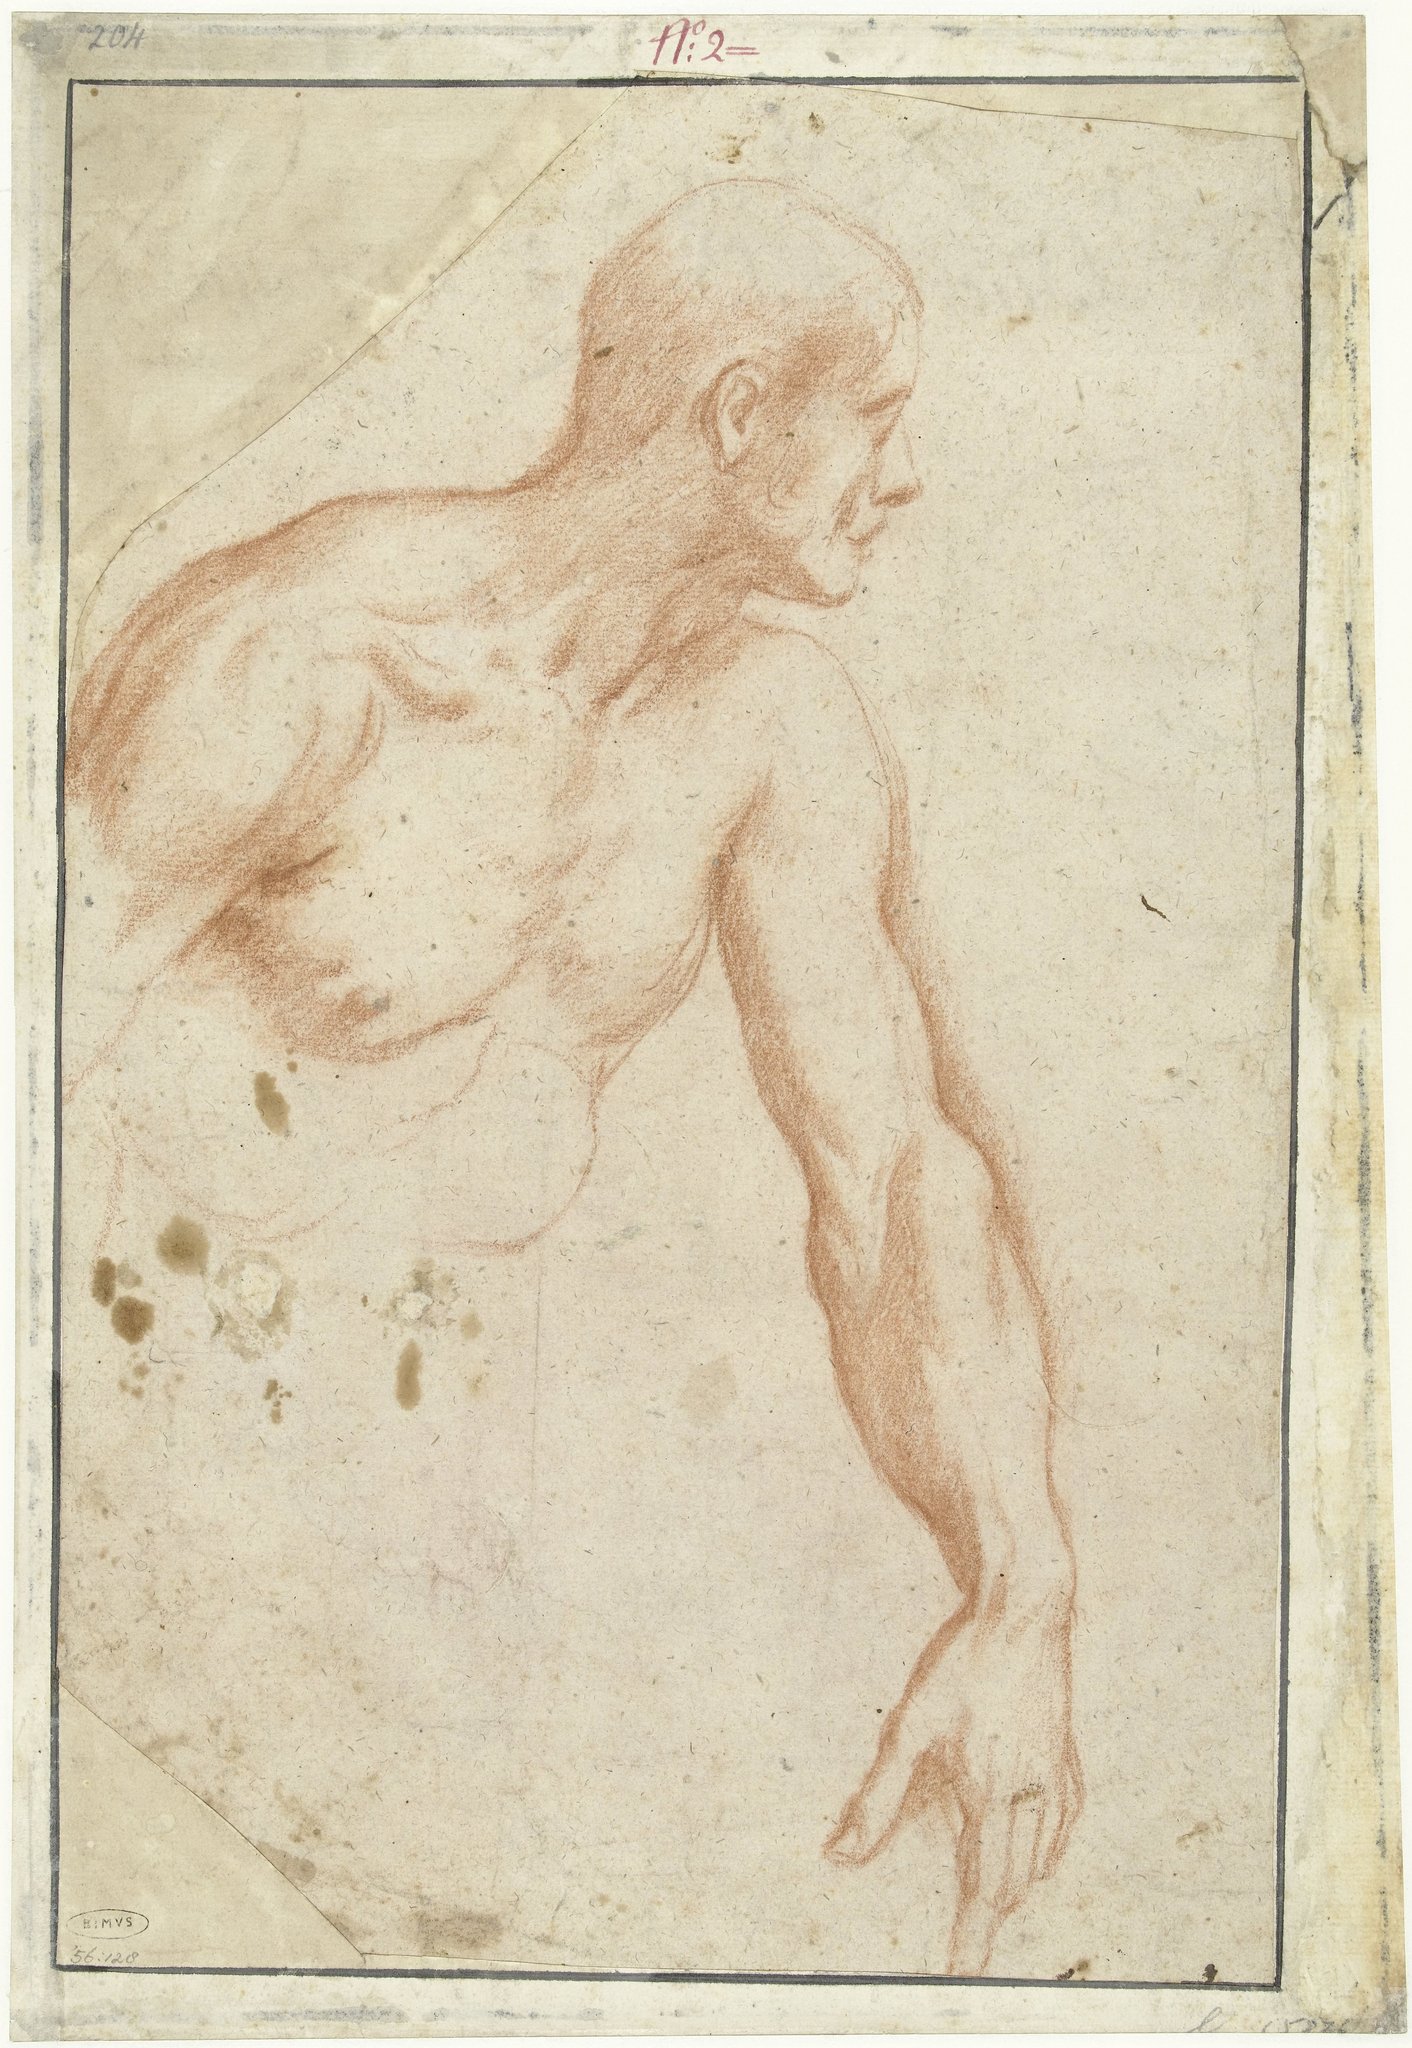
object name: drawing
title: Naaktstudie van een naar rechts gewende man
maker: pietro sorri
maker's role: draughtsman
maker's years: 1556-1622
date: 1609-1614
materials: chalk, paper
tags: chest, bust